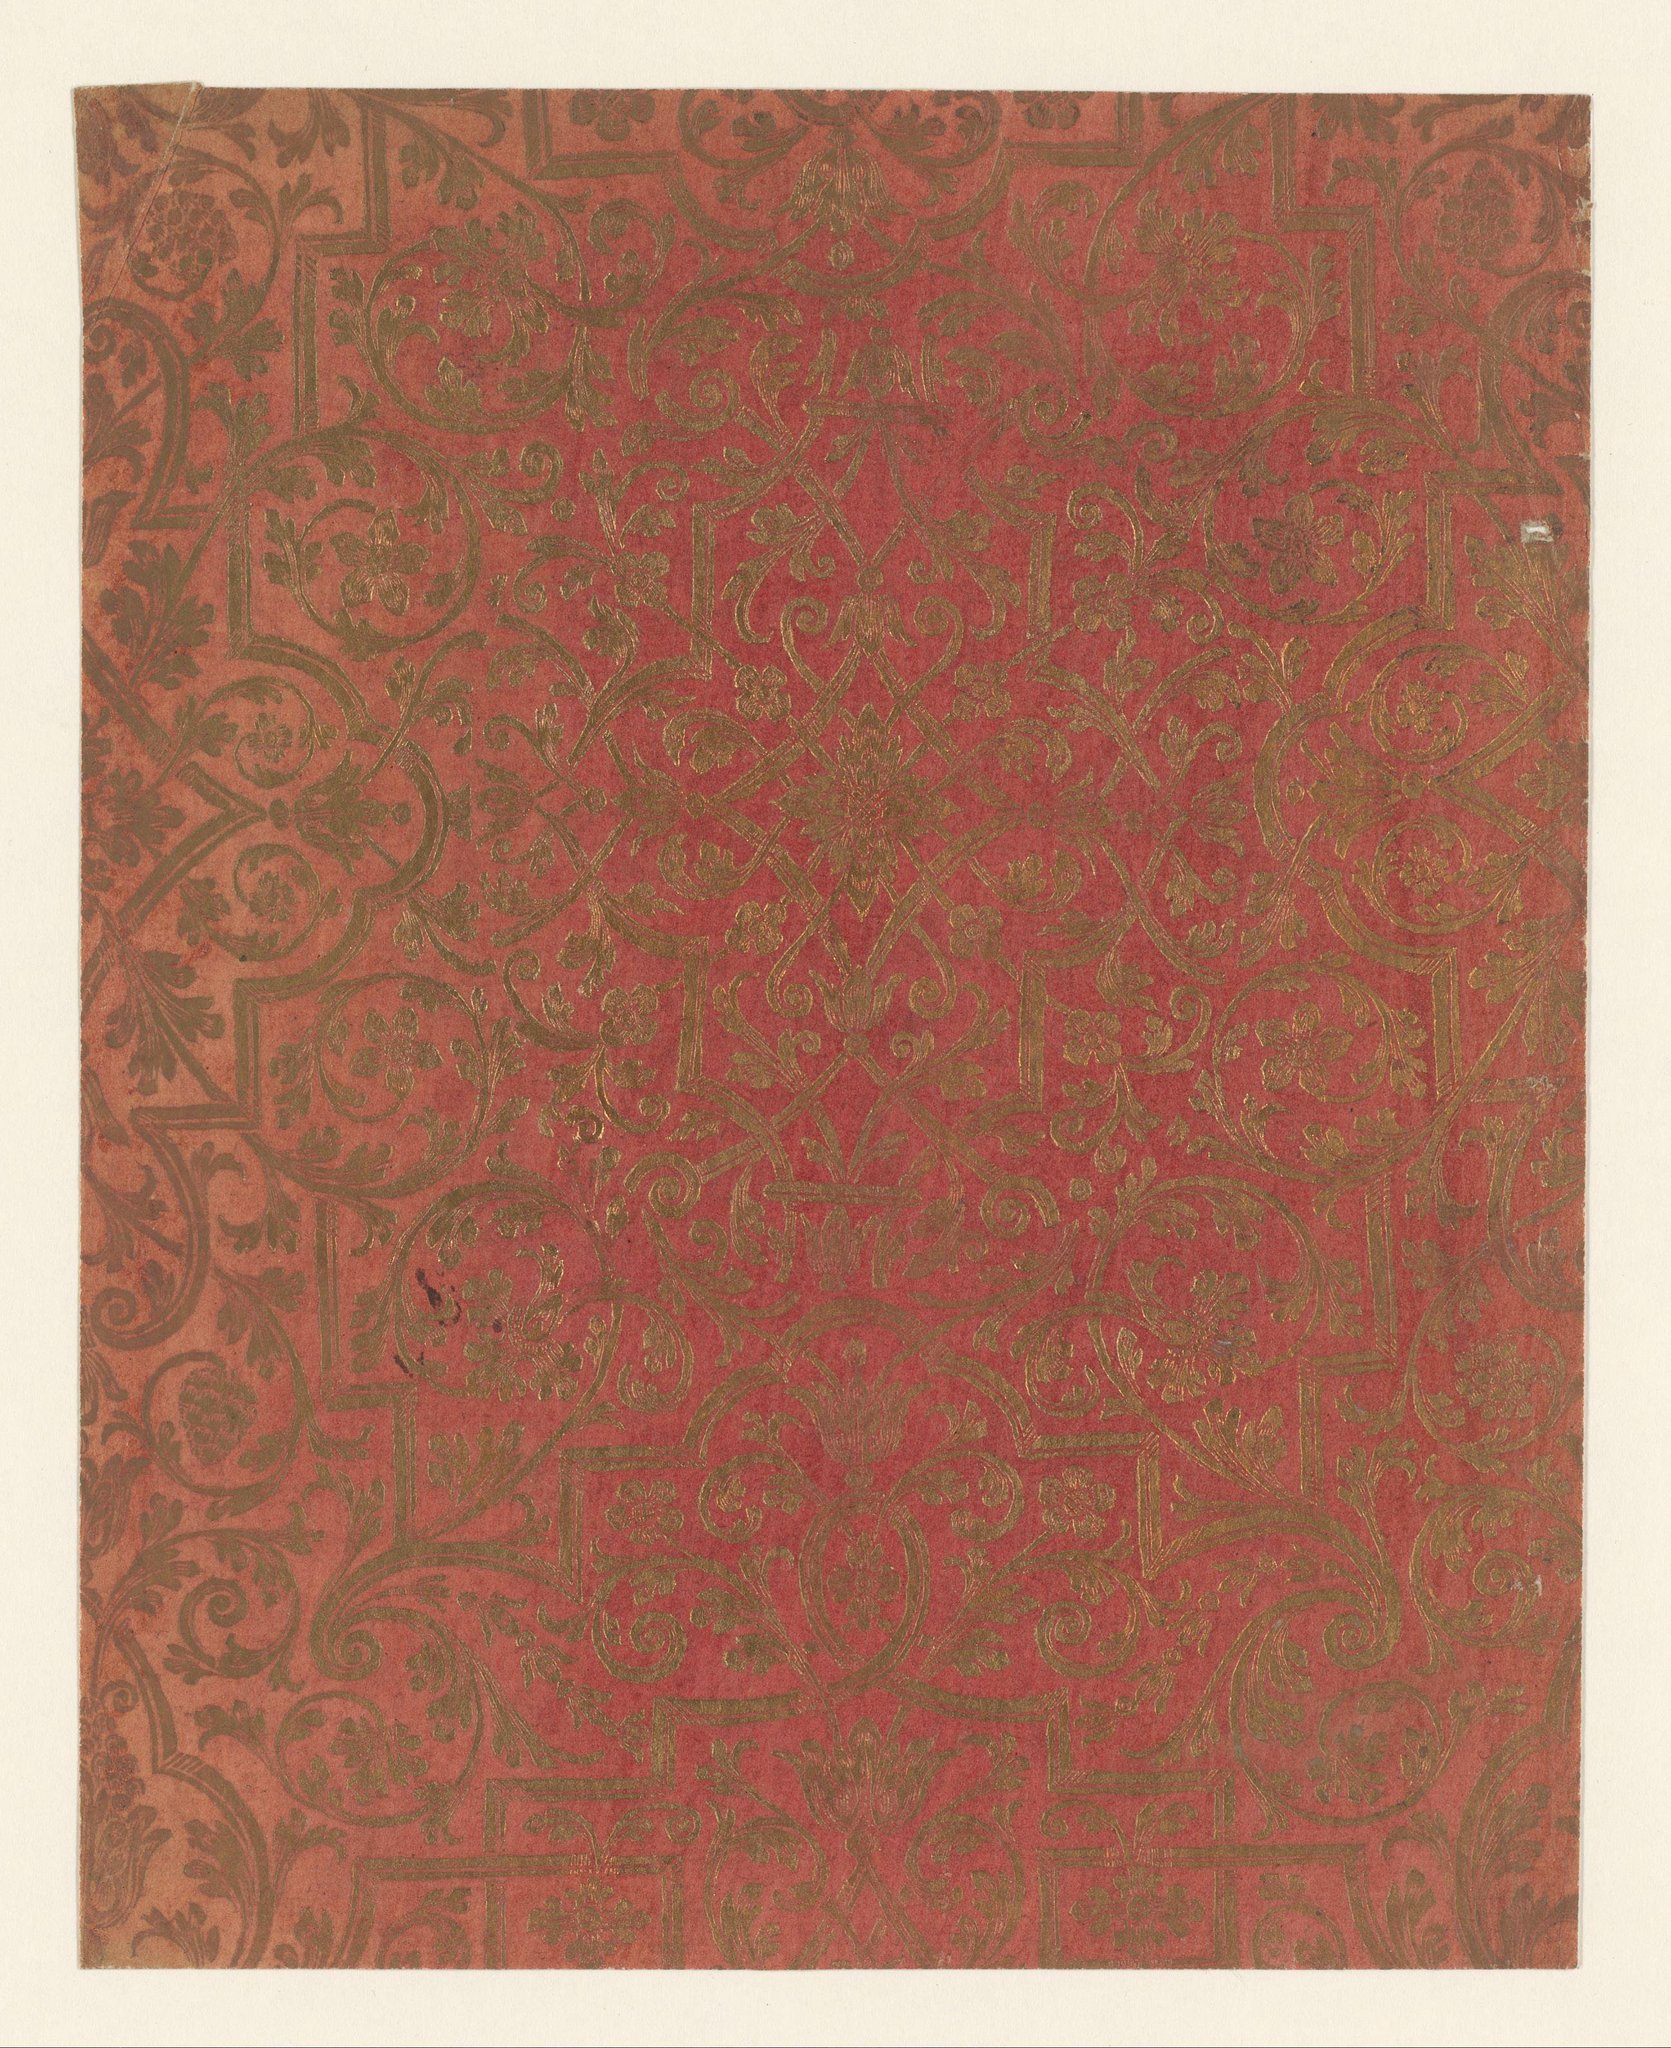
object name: brocade paper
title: Blad met patroon van ranken en bandwerk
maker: Anonymous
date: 1700-1850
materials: gold leaf, paper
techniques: relief print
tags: ornament derived from plant forms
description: Blad met patroon van ranken met bloemen en bandwerk. Mogelijk deel van een omslag.